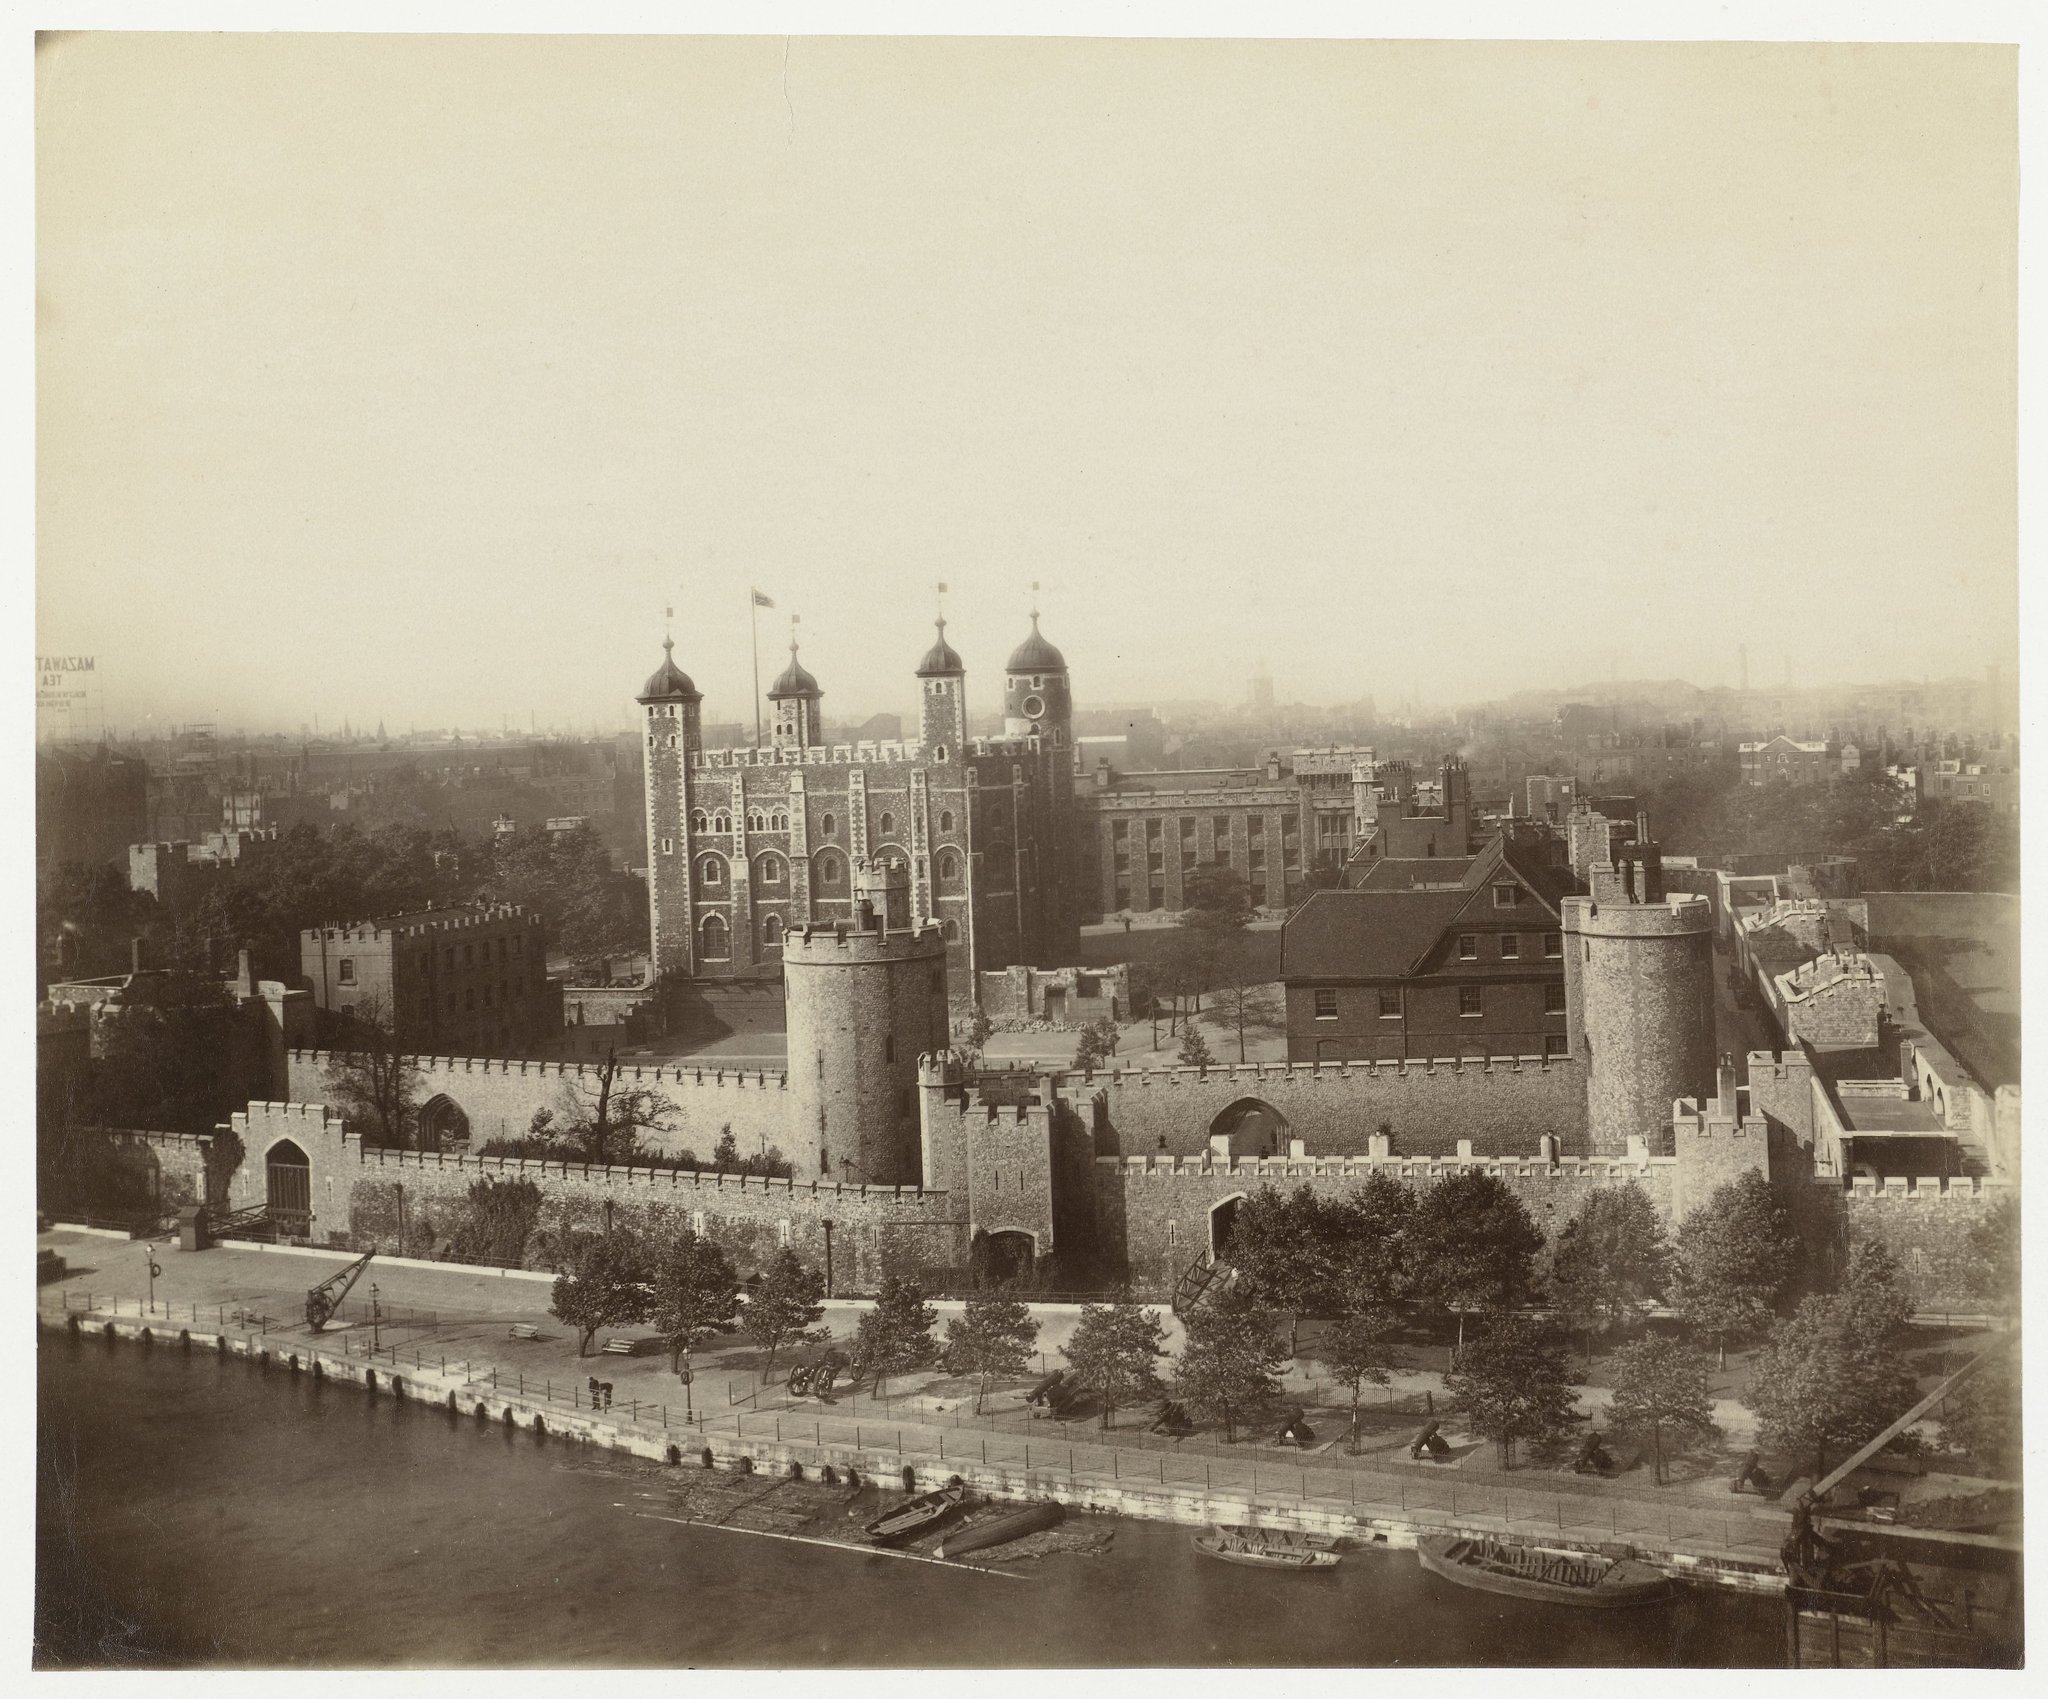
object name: photograph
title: Tower of London gezien vanaf de Tower Bridge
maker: Anonymous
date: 1855-1900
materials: cardboard, paper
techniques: albumen print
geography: london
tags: fortress, thames